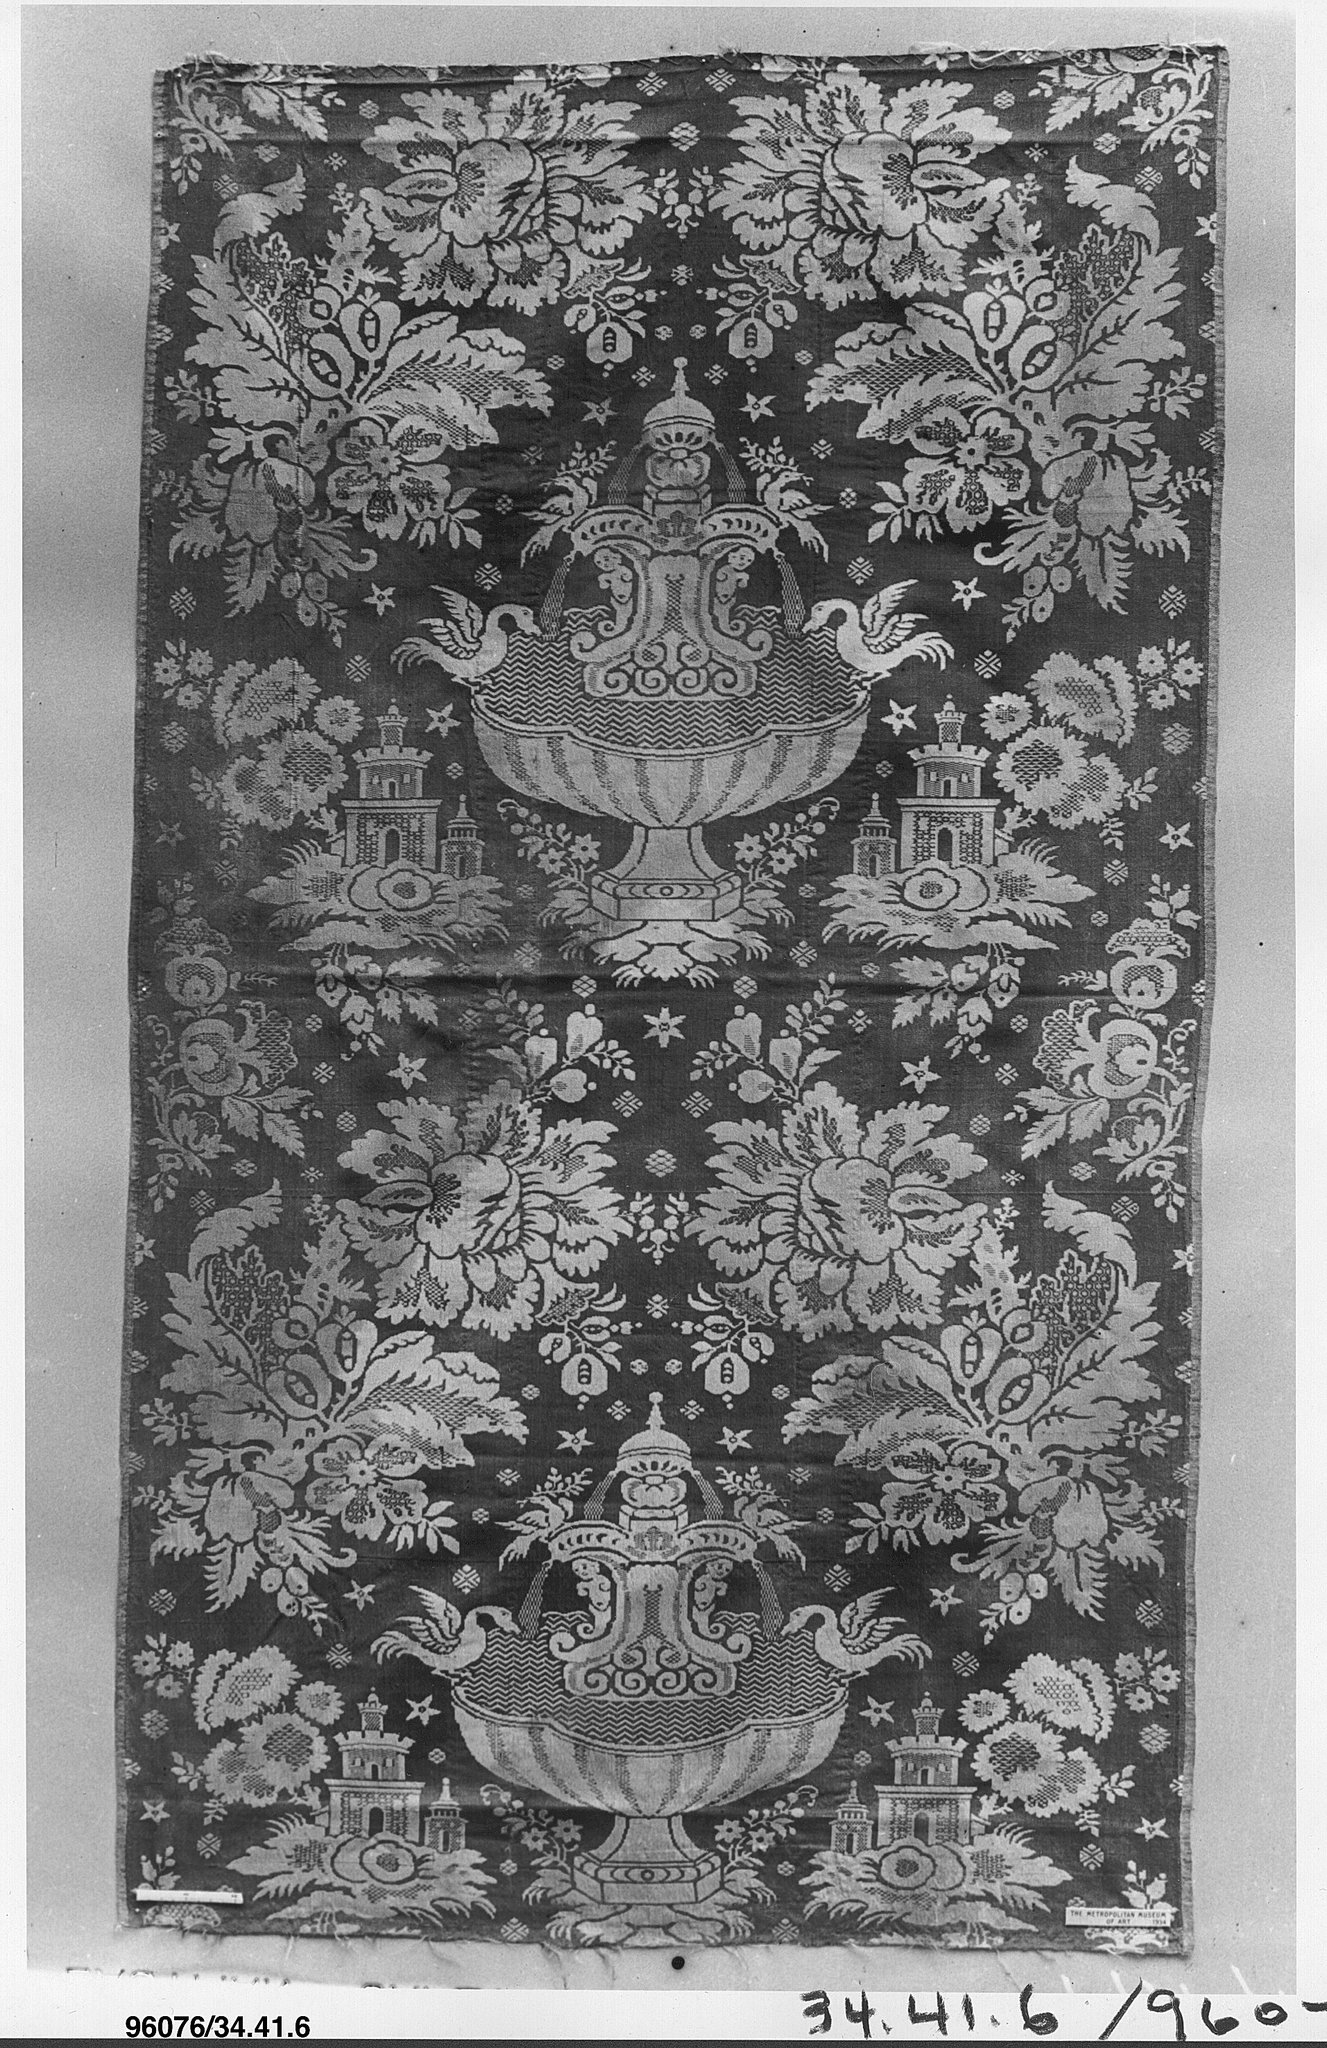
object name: piece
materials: silk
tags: birds,fountains,flowers,leaves